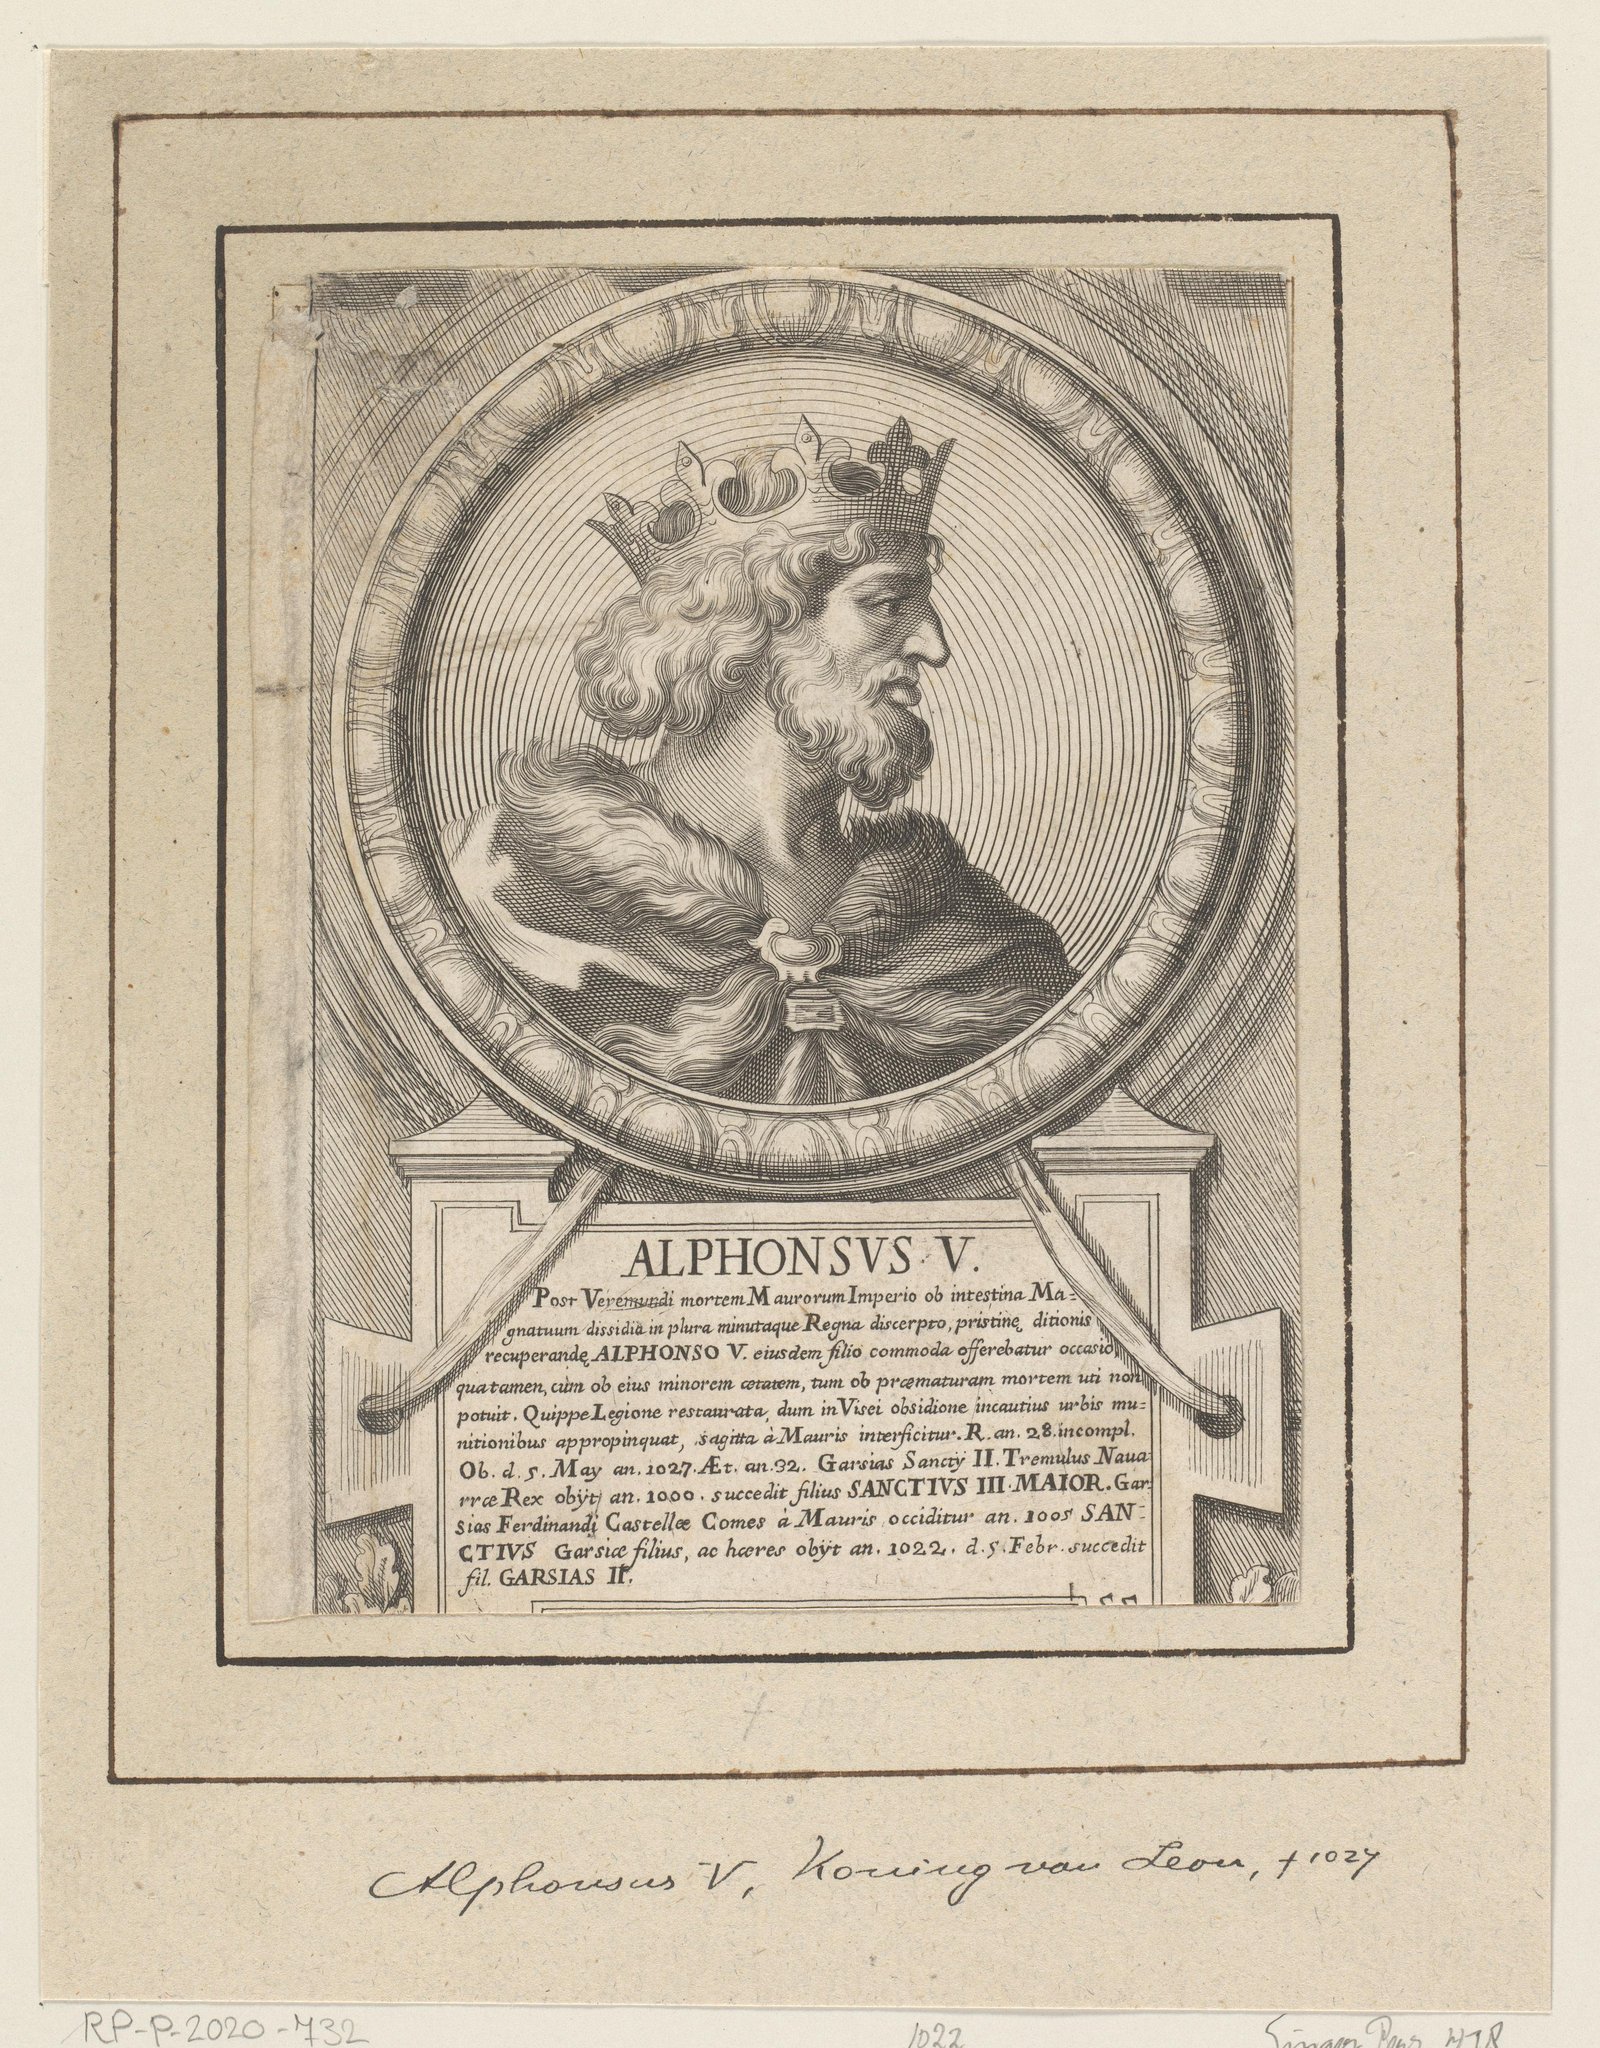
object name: print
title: Series Chronologica et Imagines Regu Hispaniae ab Ataulpho ad Carolum II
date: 1685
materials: paper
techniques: engraving, etching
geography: rome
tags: historical persons, ruler, sovereign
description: Portret afkomstig van een grote prent, getiteld 'Series Chronologica et Imagines Regu Hispaniae ab Ataulpho ad Carolum II', bestaande uit tien bladen die samengevoegd konden worden, uitgegeven door Giovanni Giacomo de' Rossi in 1685.